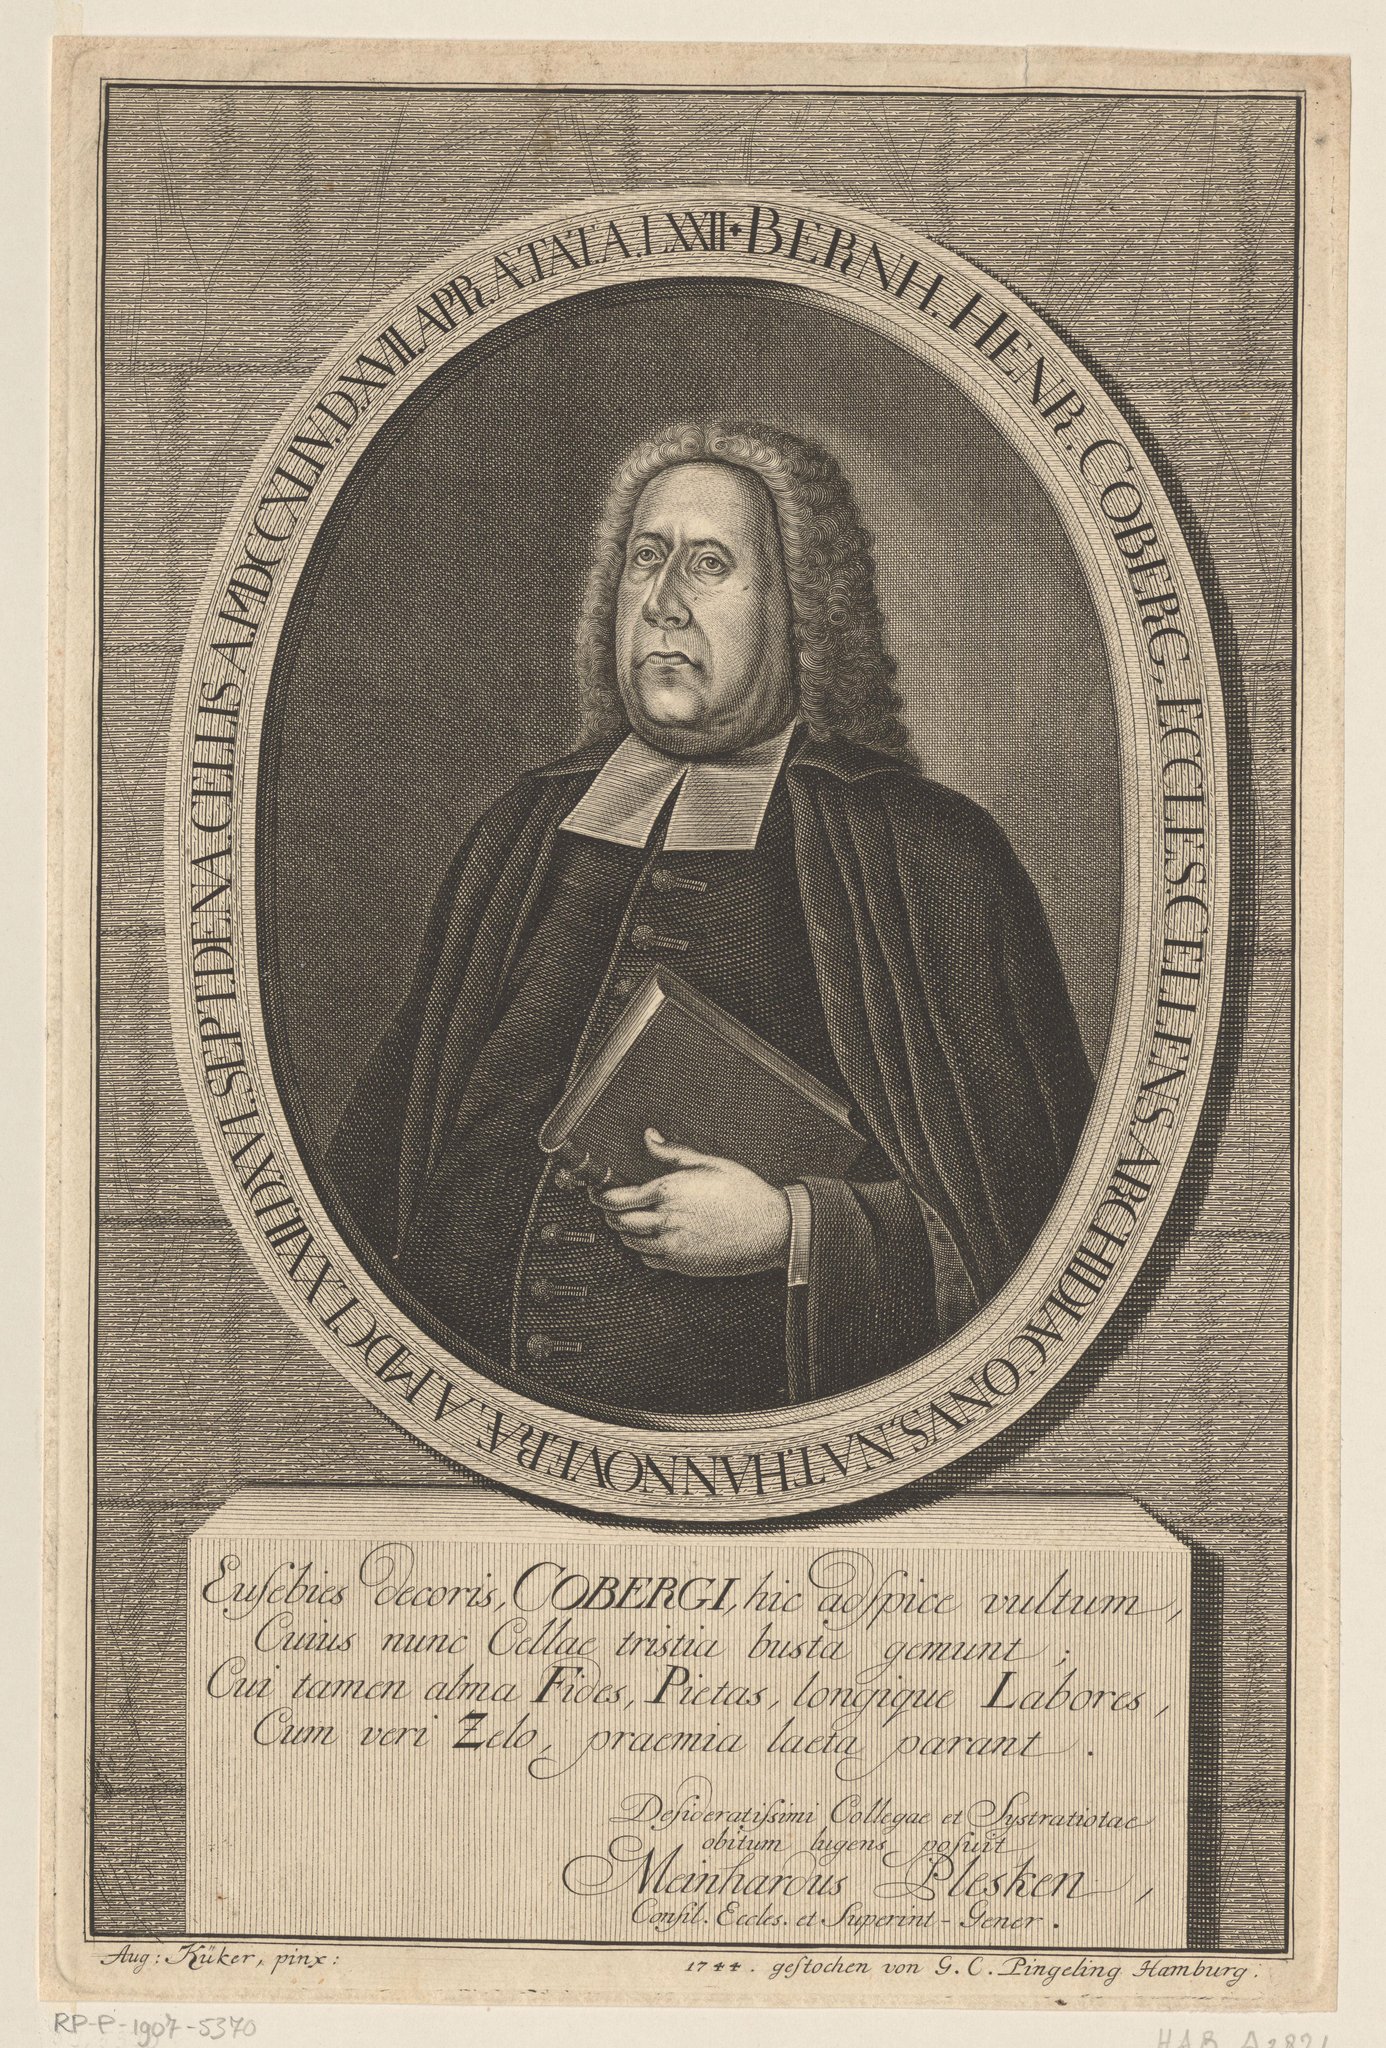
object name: print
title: Portret van Bernhard Heinrich Coberg op 72-jarige leeftijd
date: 1744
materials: paper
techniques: engraving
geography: hamburg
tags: historical persons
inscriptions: collector's mark: Lugt 2228